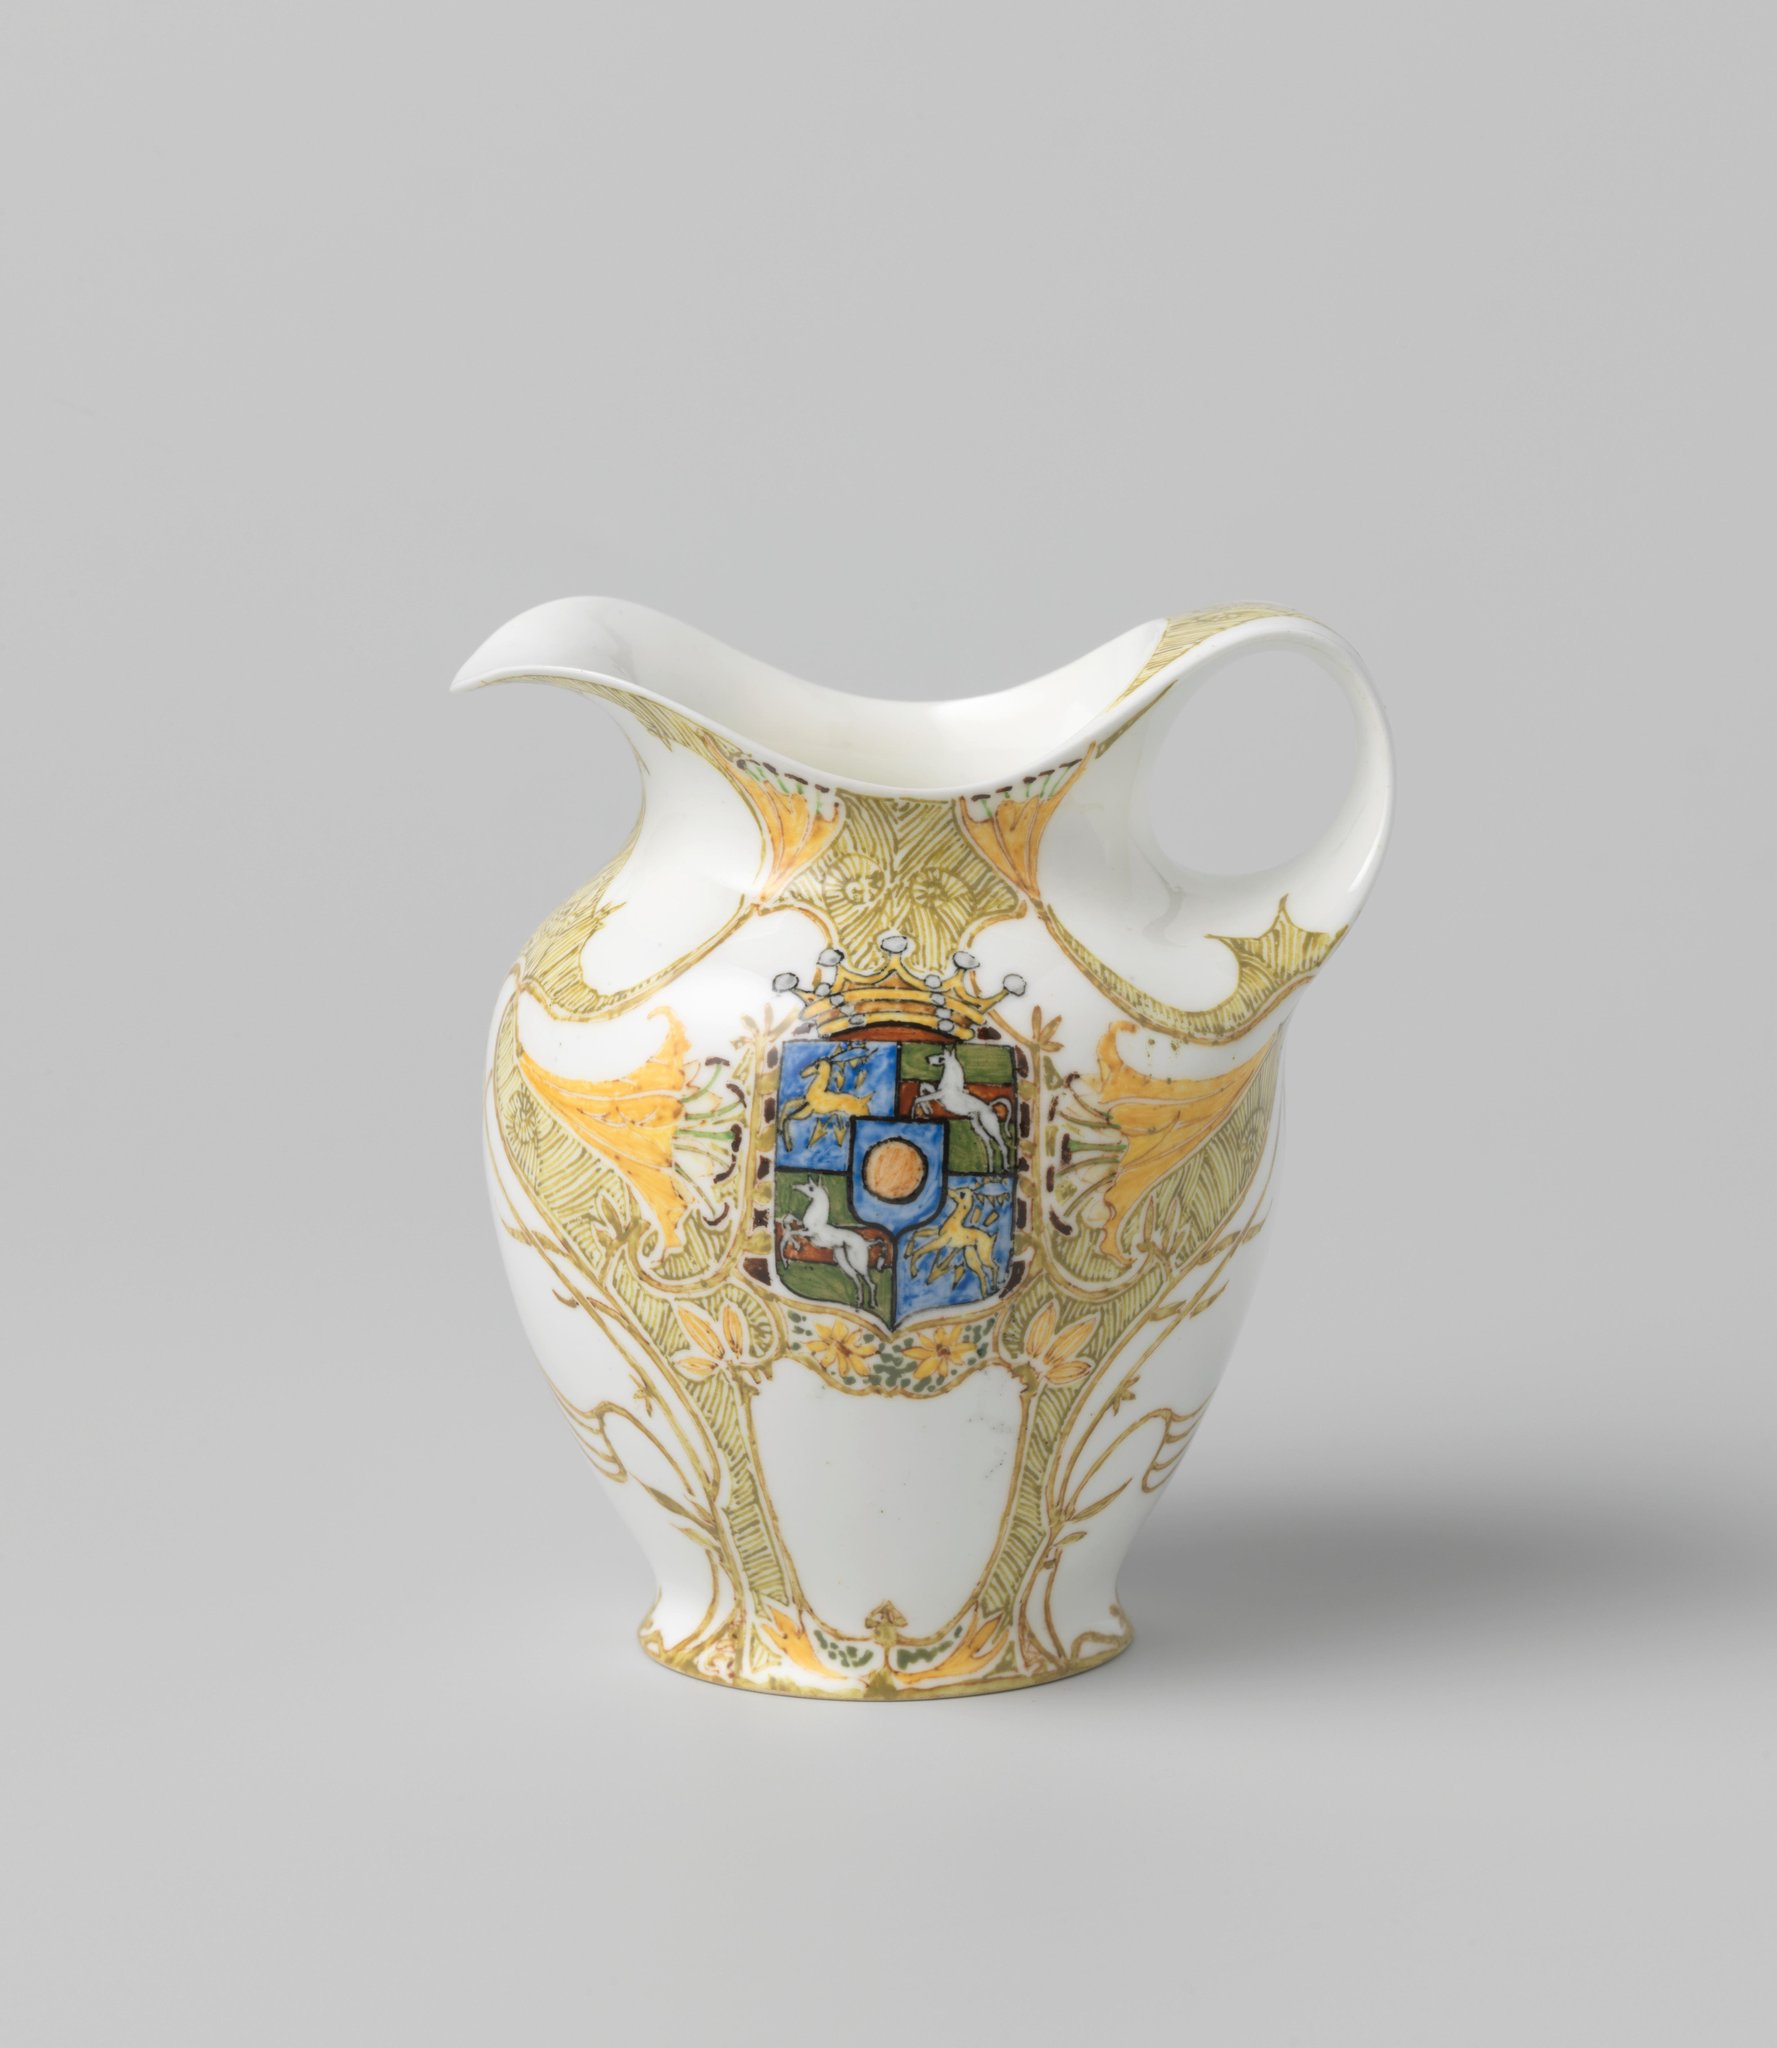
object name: milk jug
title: Melkkan, deel van een tête-à-tête, beschilderd met lelies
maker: jacob willem van rossum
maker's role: print maker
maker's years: 1881-1963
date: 1900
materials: porcelain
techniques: painted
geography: the hague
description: Melkkan van een tête-à-tête van porselein. Beschilderd in geel, roodbruin en verschillende tinten groen met een ornamentaal decor, waarin lelies. Op alle delen het monogram MvV (= Michiels van Verduynen) en het wapen van deze familie, waarin ook nog de kleur blauw voorkomt. Gemerkt Rozenburg.